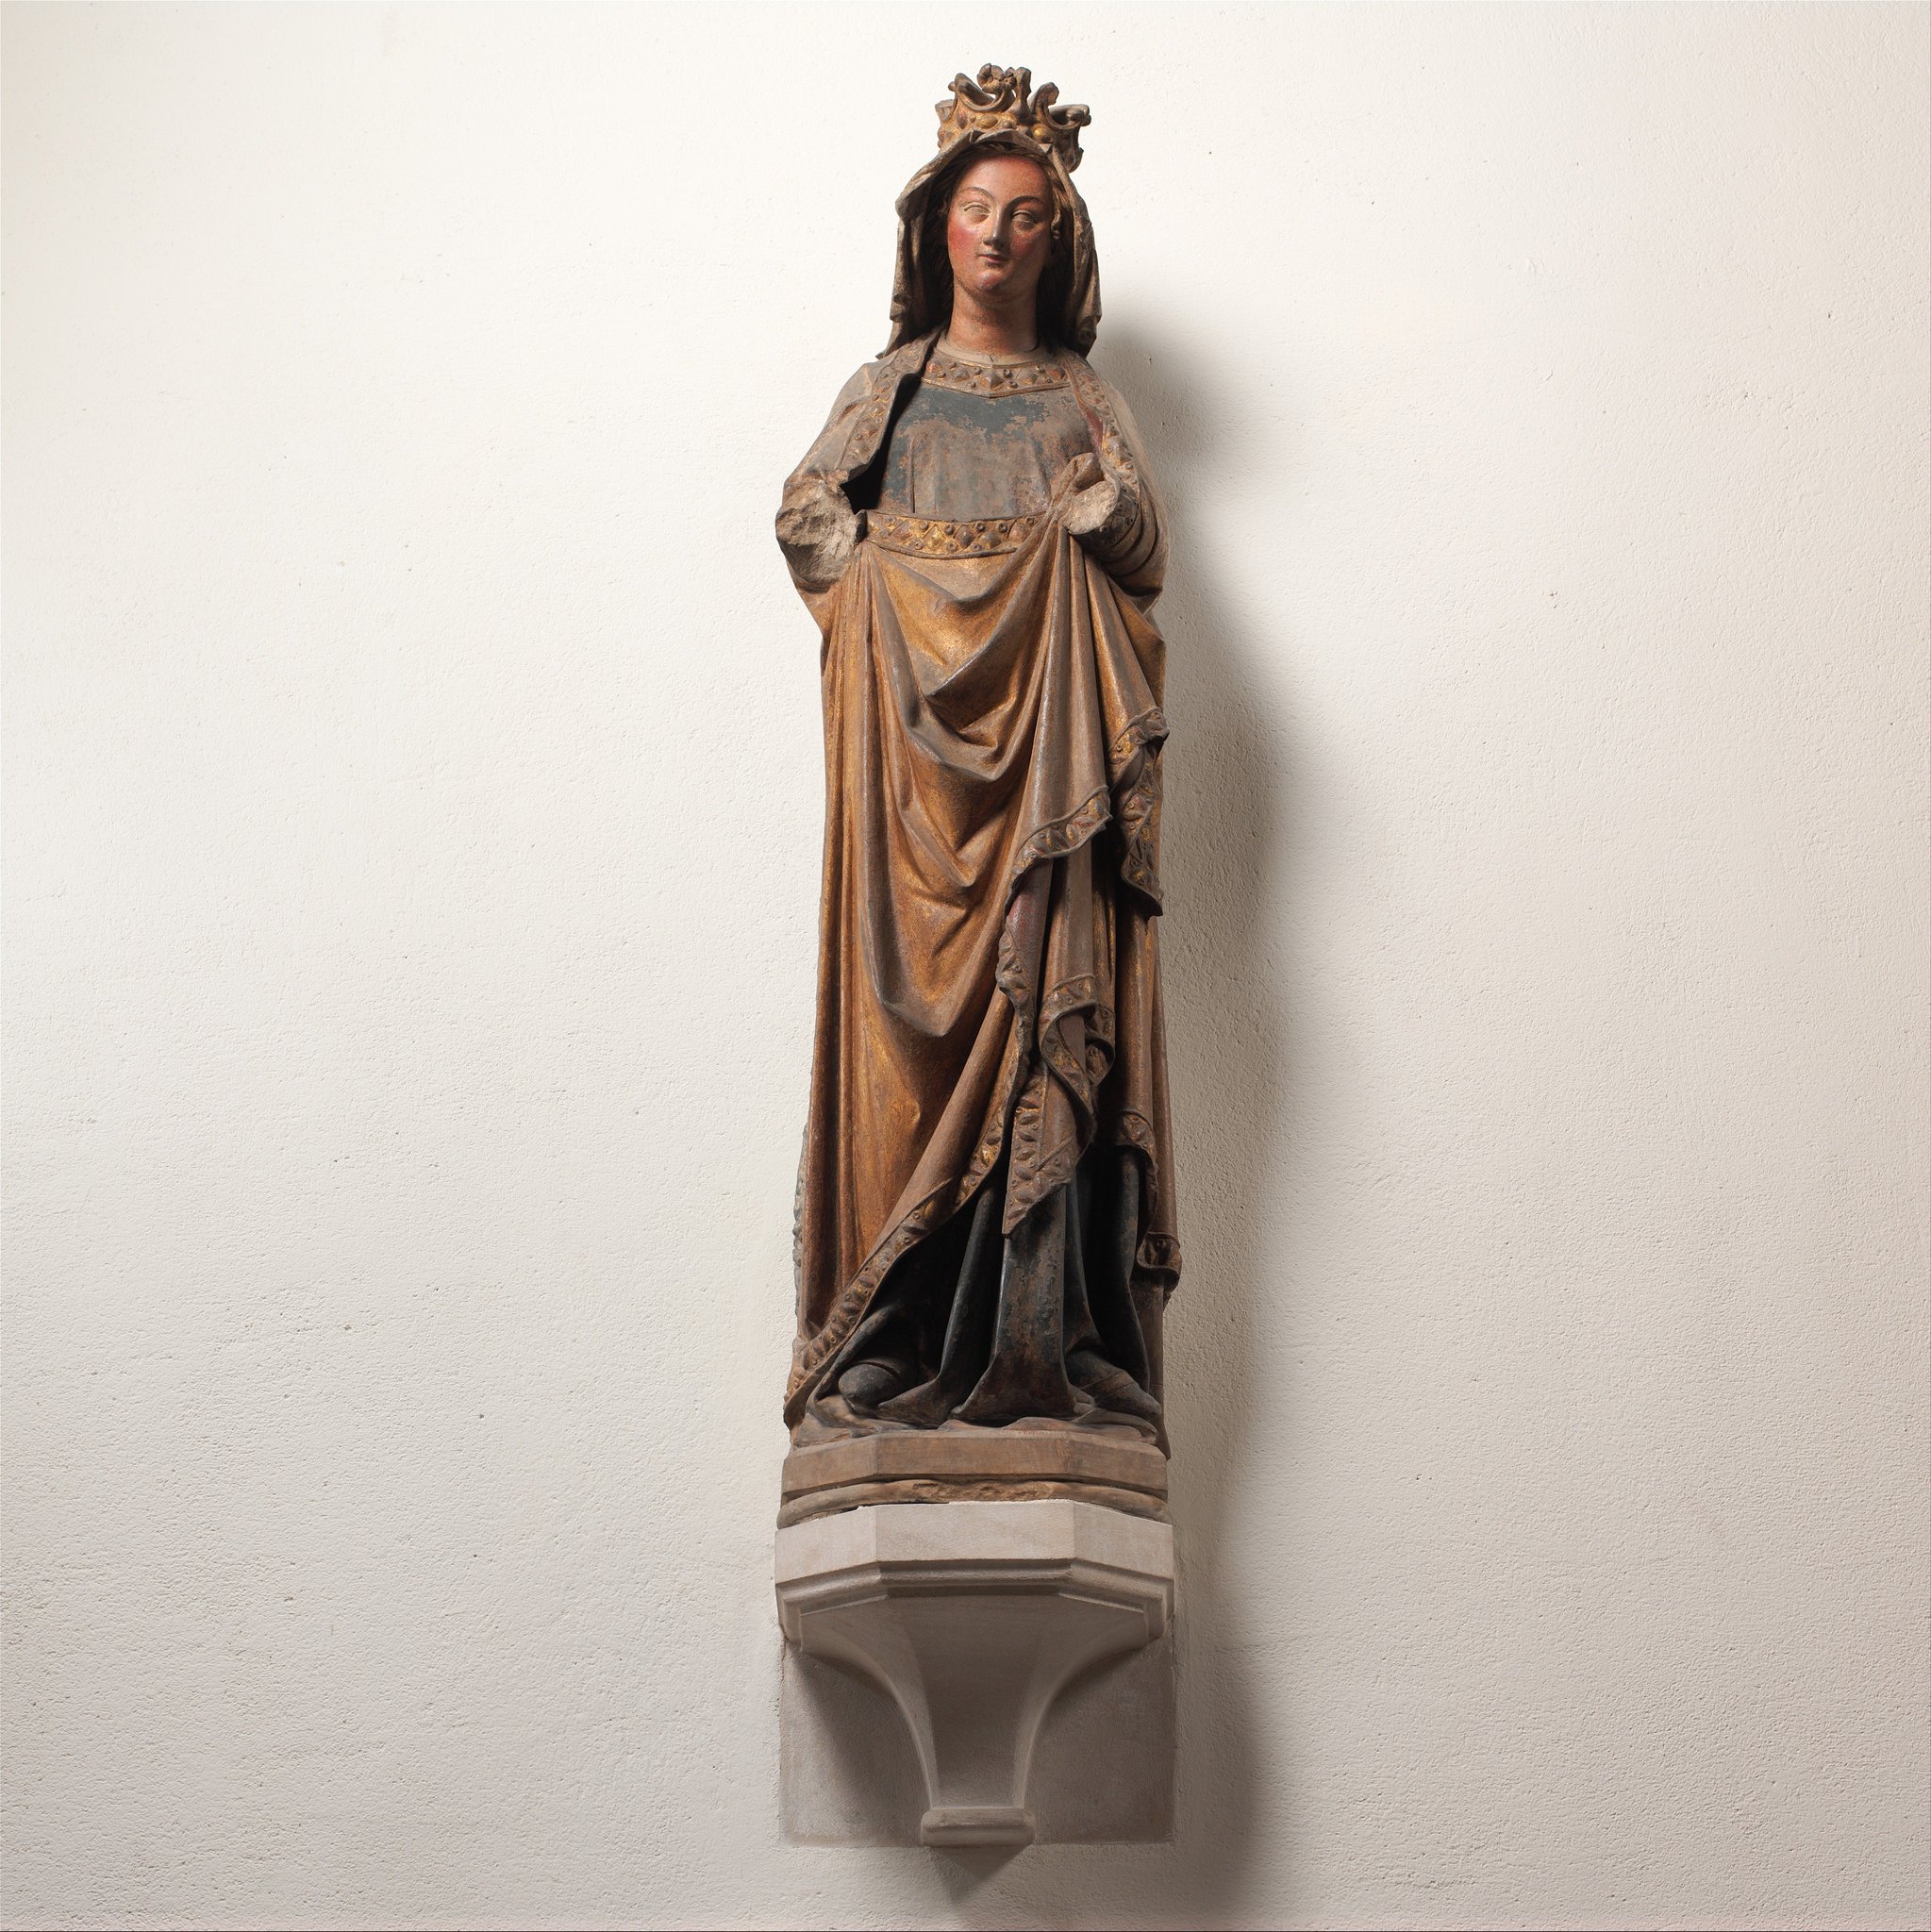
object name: statue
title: Virgin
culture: german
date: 1250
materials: paint, stone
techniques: gilding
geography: france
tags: women,virgin mary